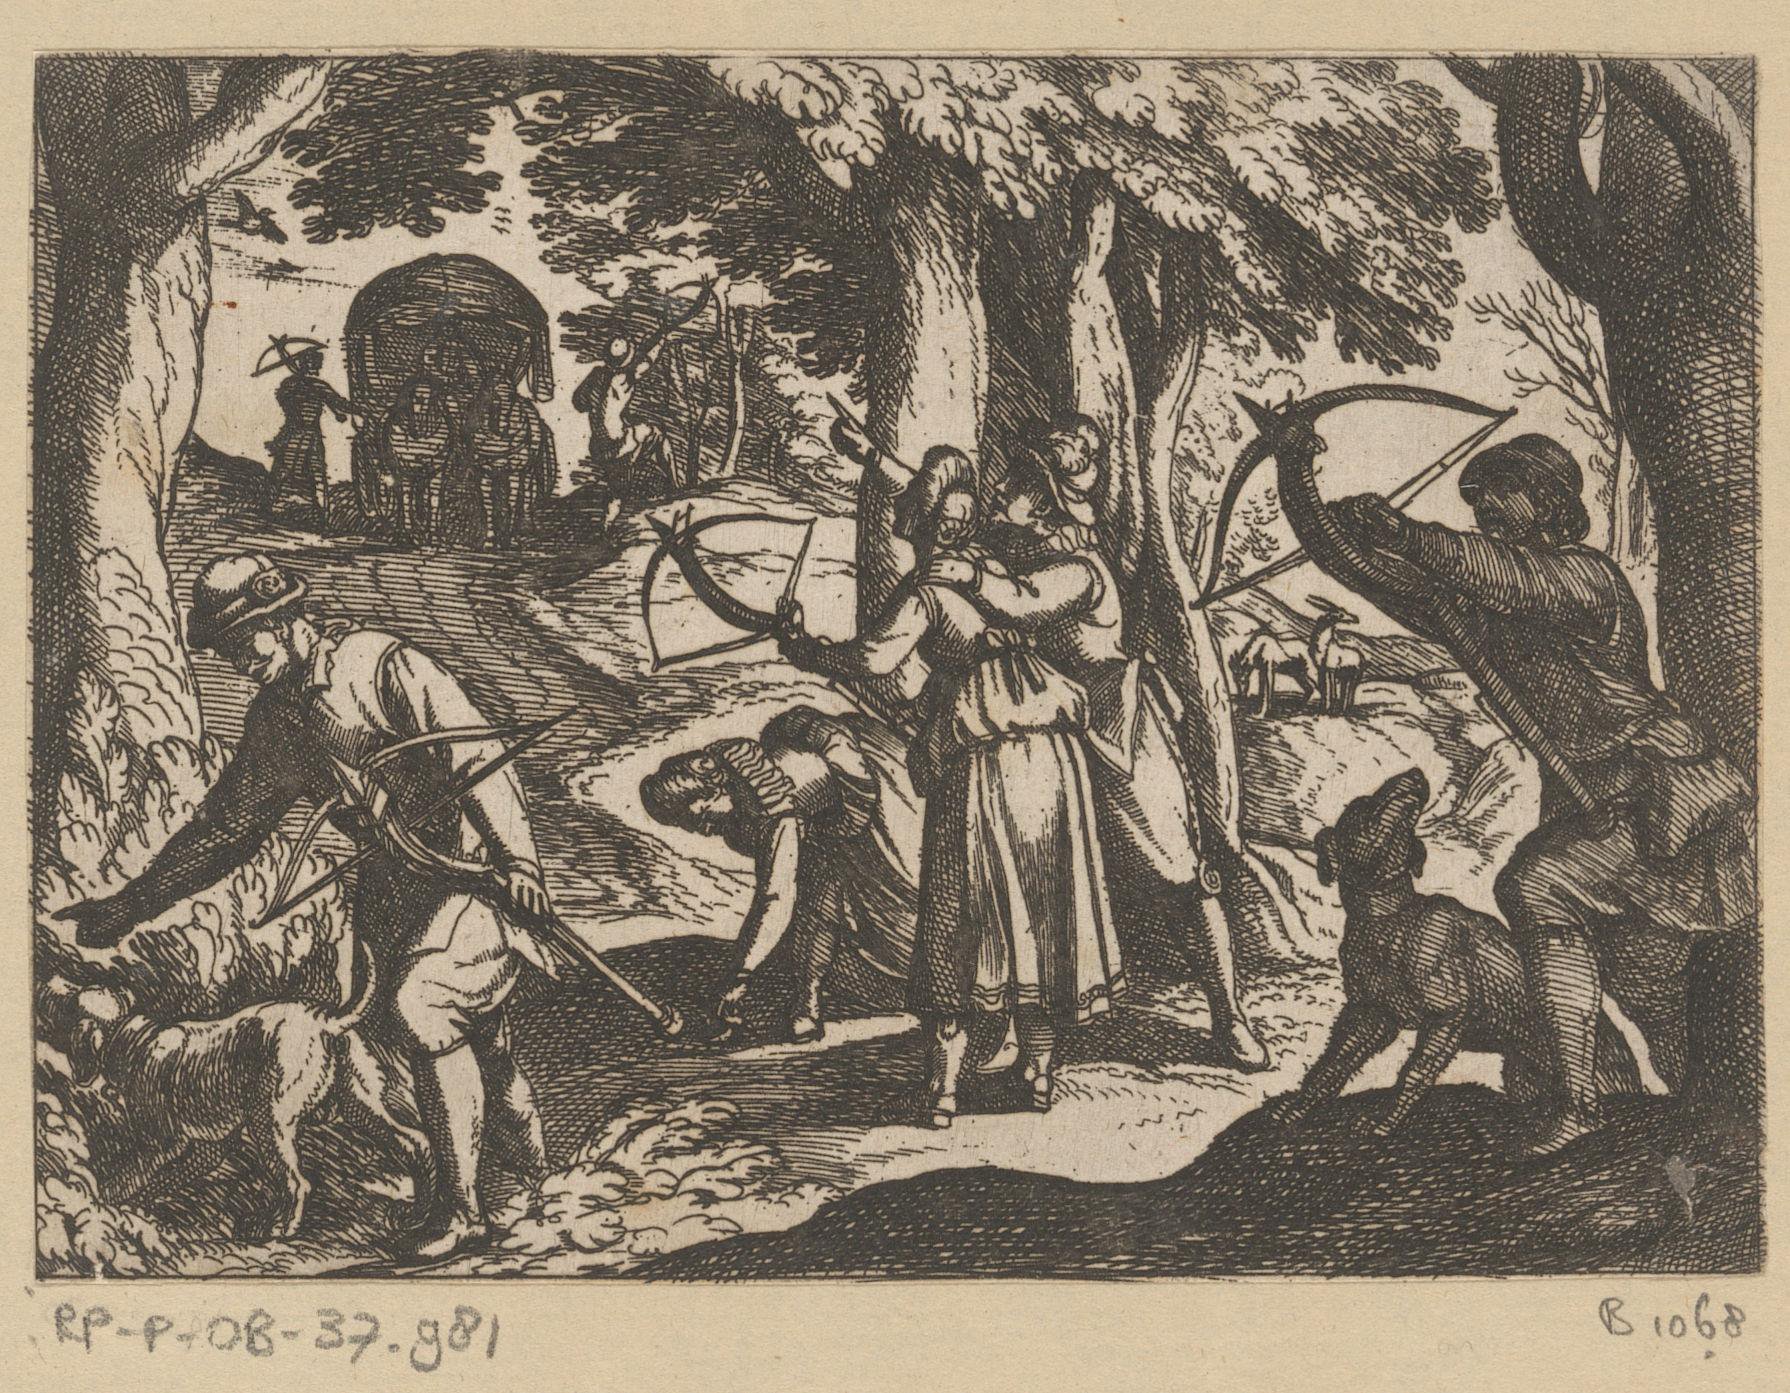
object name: print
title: Jachtscènes (deel 2)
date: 1598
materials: paper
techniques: etching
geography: italy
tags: hunter, hunters hunting (n.b.: in 1988-1990 this notation denoted the concept of 43c11421 'hunters resting during the hunt'), bird hunting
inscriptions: collector's mark: Lugt 240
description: Deze prent maakt deel uit van een reeks van 45 jachtscènes (+ titelprent en opdracht).